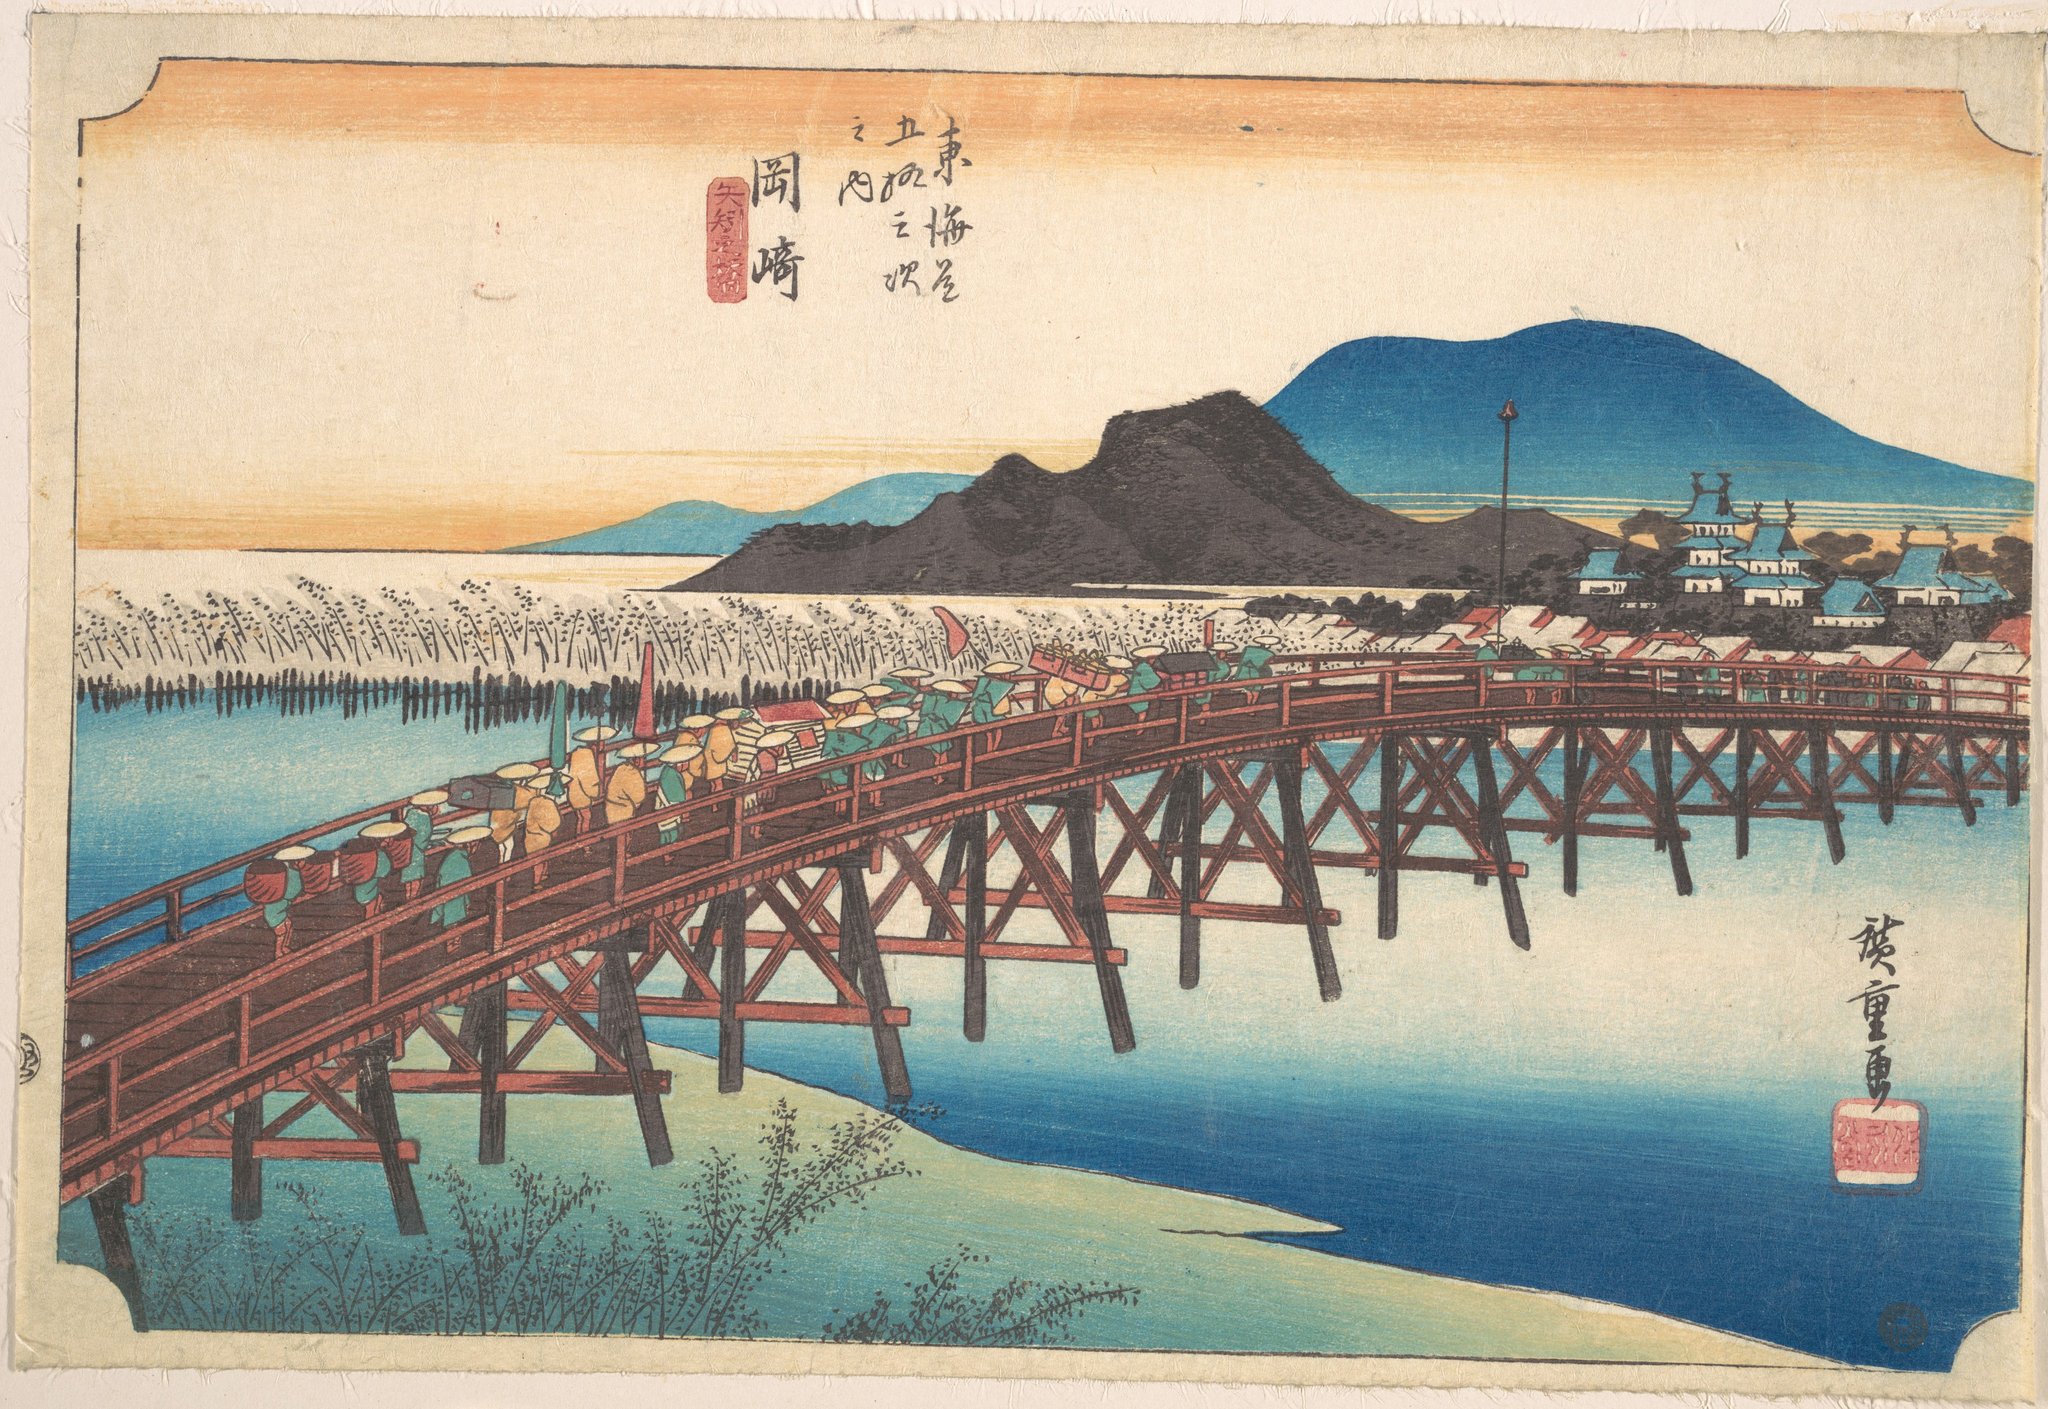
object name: print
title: Okazaki, Tenshin no Hashi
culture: japanese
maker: utagawa hiroshige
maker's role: artist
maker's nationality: japanese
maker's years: 1797-1858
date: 1834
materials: ink, paper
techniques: woodblock print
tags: human figures,bridges,rivers,hills